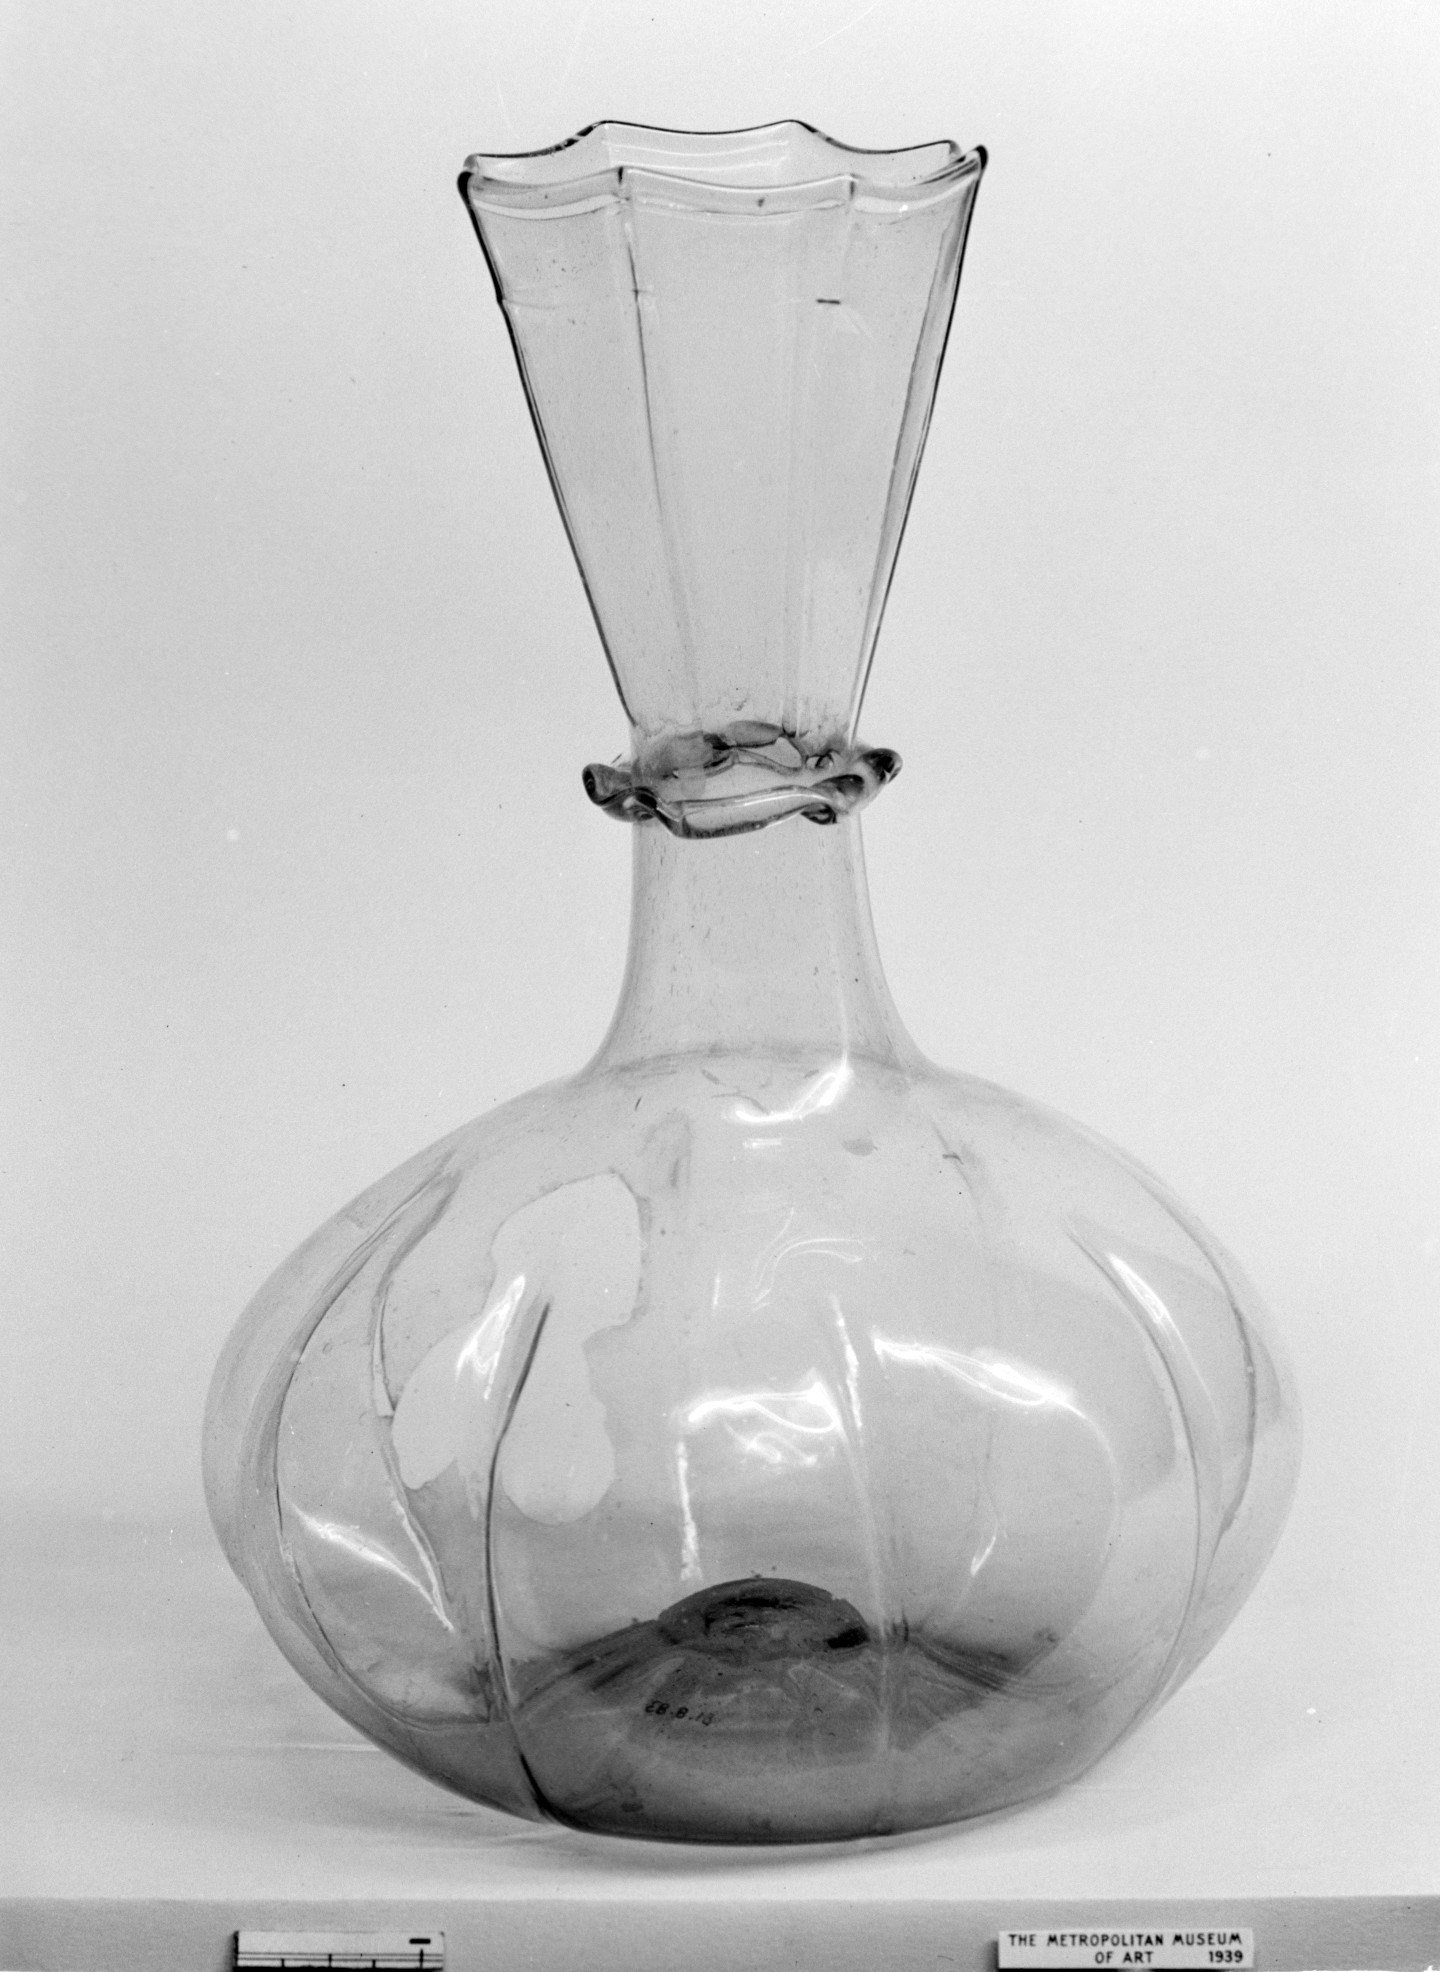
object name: carafe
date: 1801-1900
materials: glass